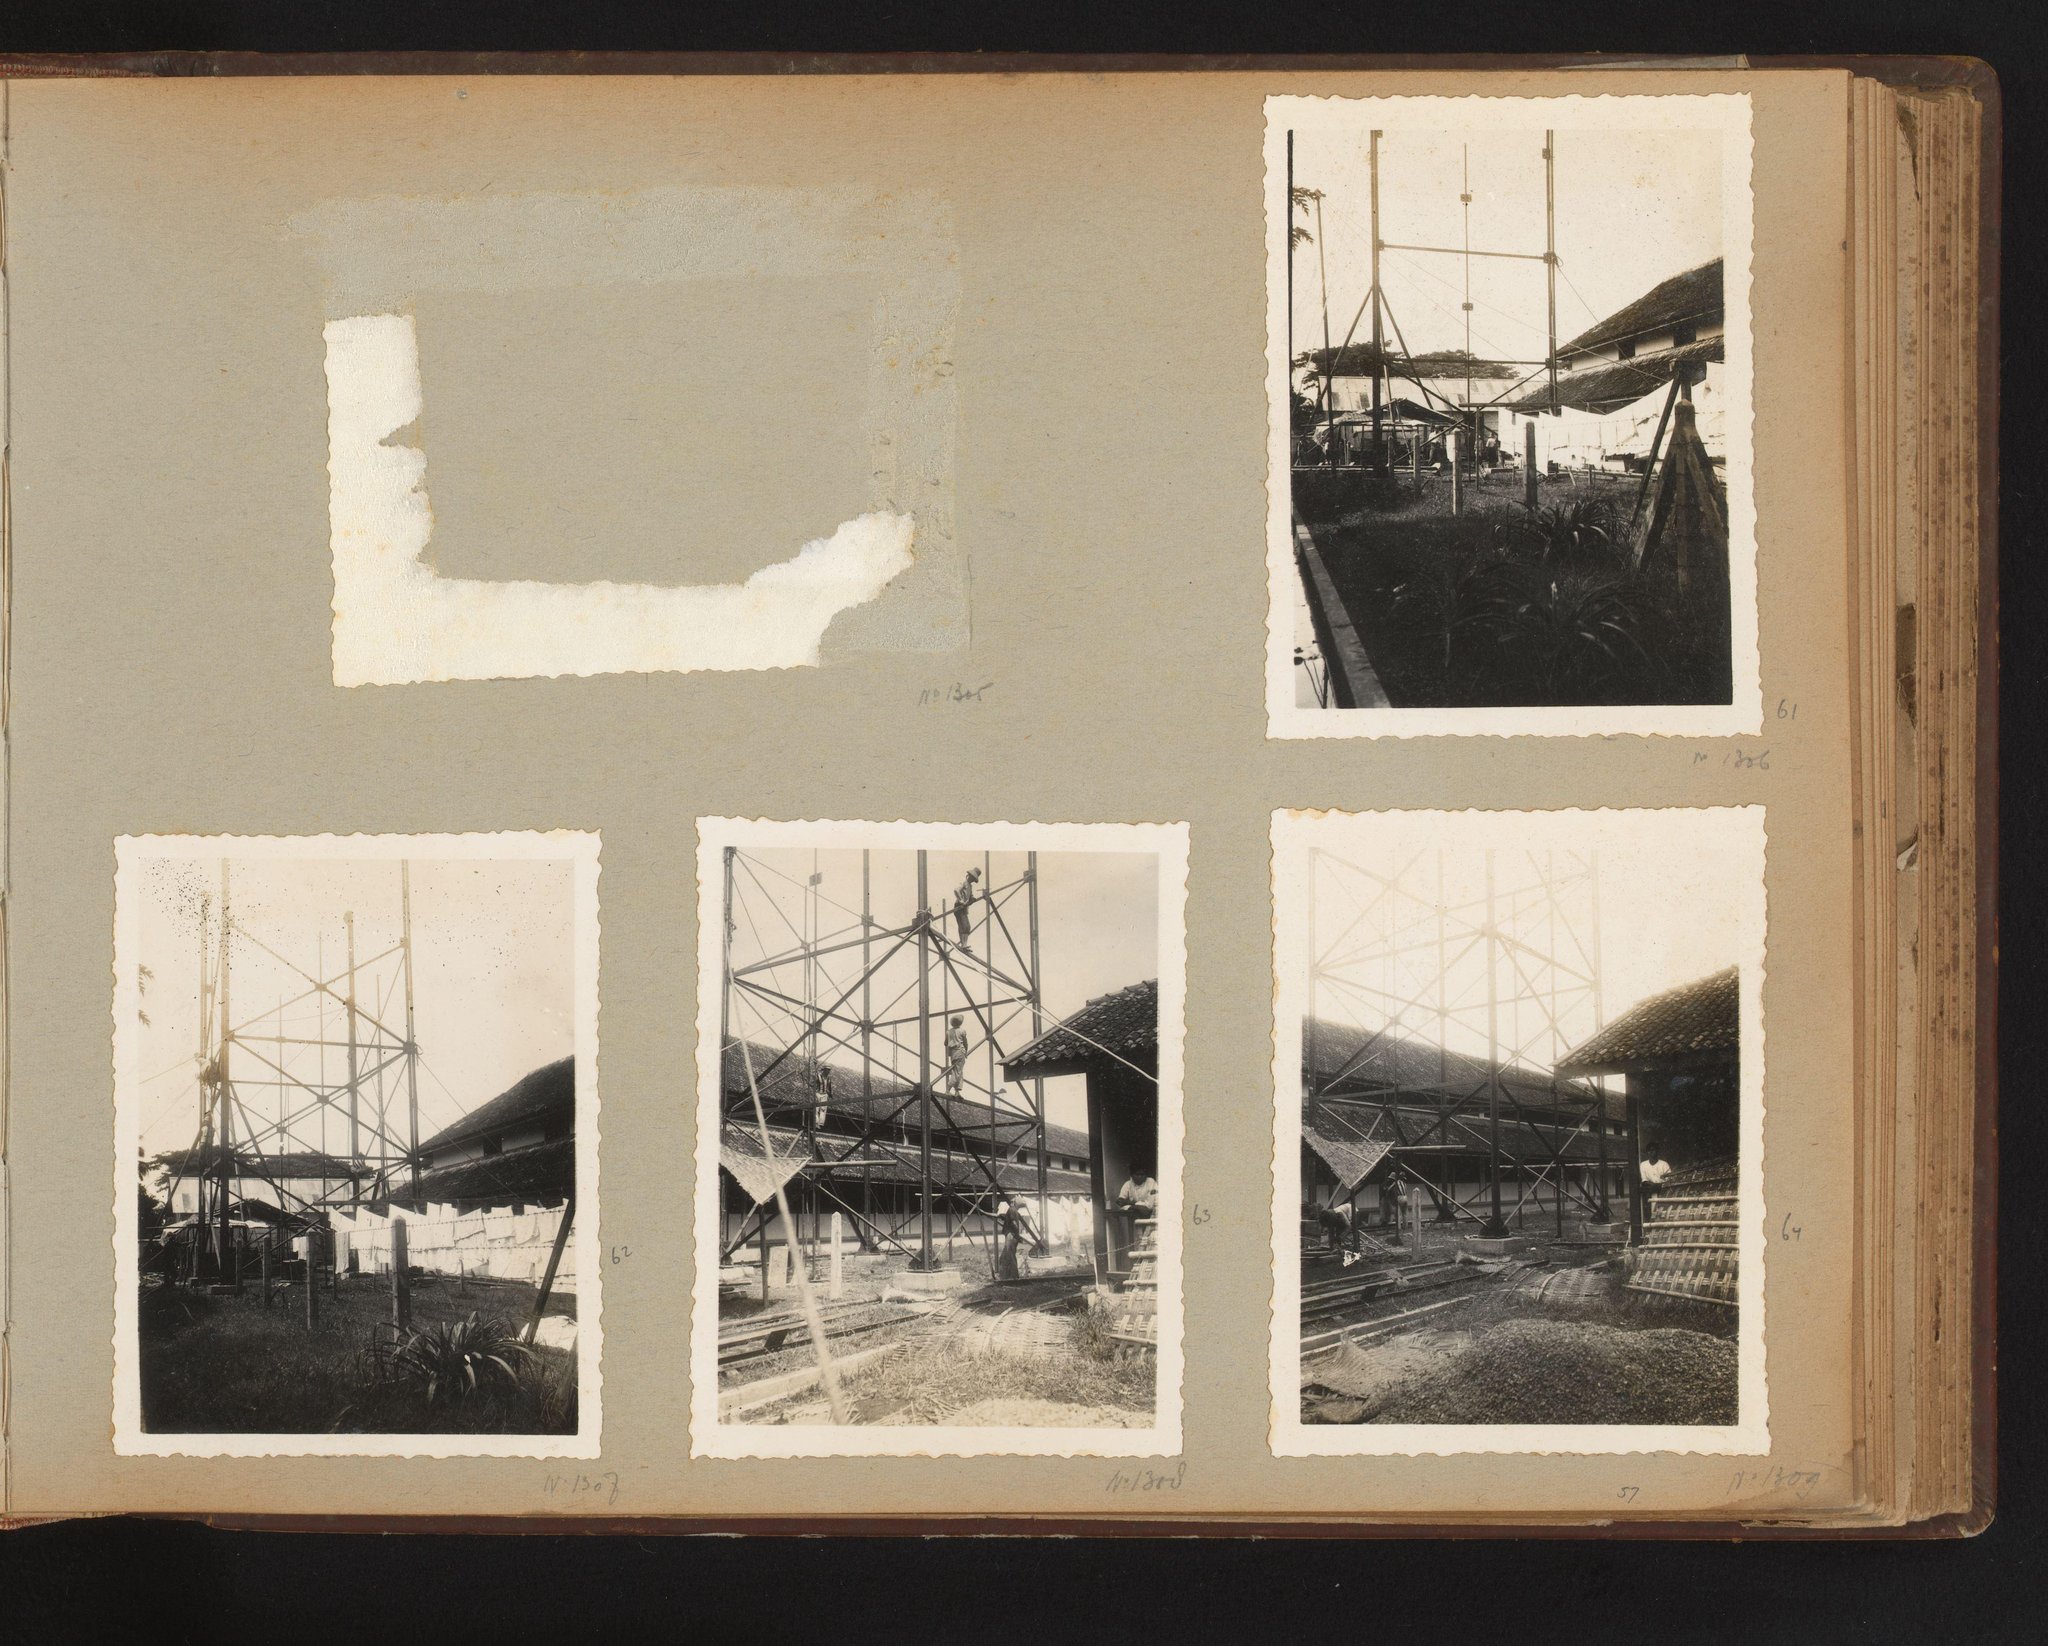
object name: photograph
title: Stalen geraamte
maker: Anonymous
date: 1931-1937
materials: cardboard, photographic support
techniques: gelatin silver print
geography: java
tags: making the overground structures (~ building activities), java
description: Albumblad met vier foto's van de opbouw van een stalen constructie, mogelijk de basis van een toren op vier poten. Onderdeel van een fotoalbum met foto's van machines en constructies van de N.V. Machinefabriek Braat te Soerabaja, Soekaboemi en Tegal uit de periode 1931-1937.